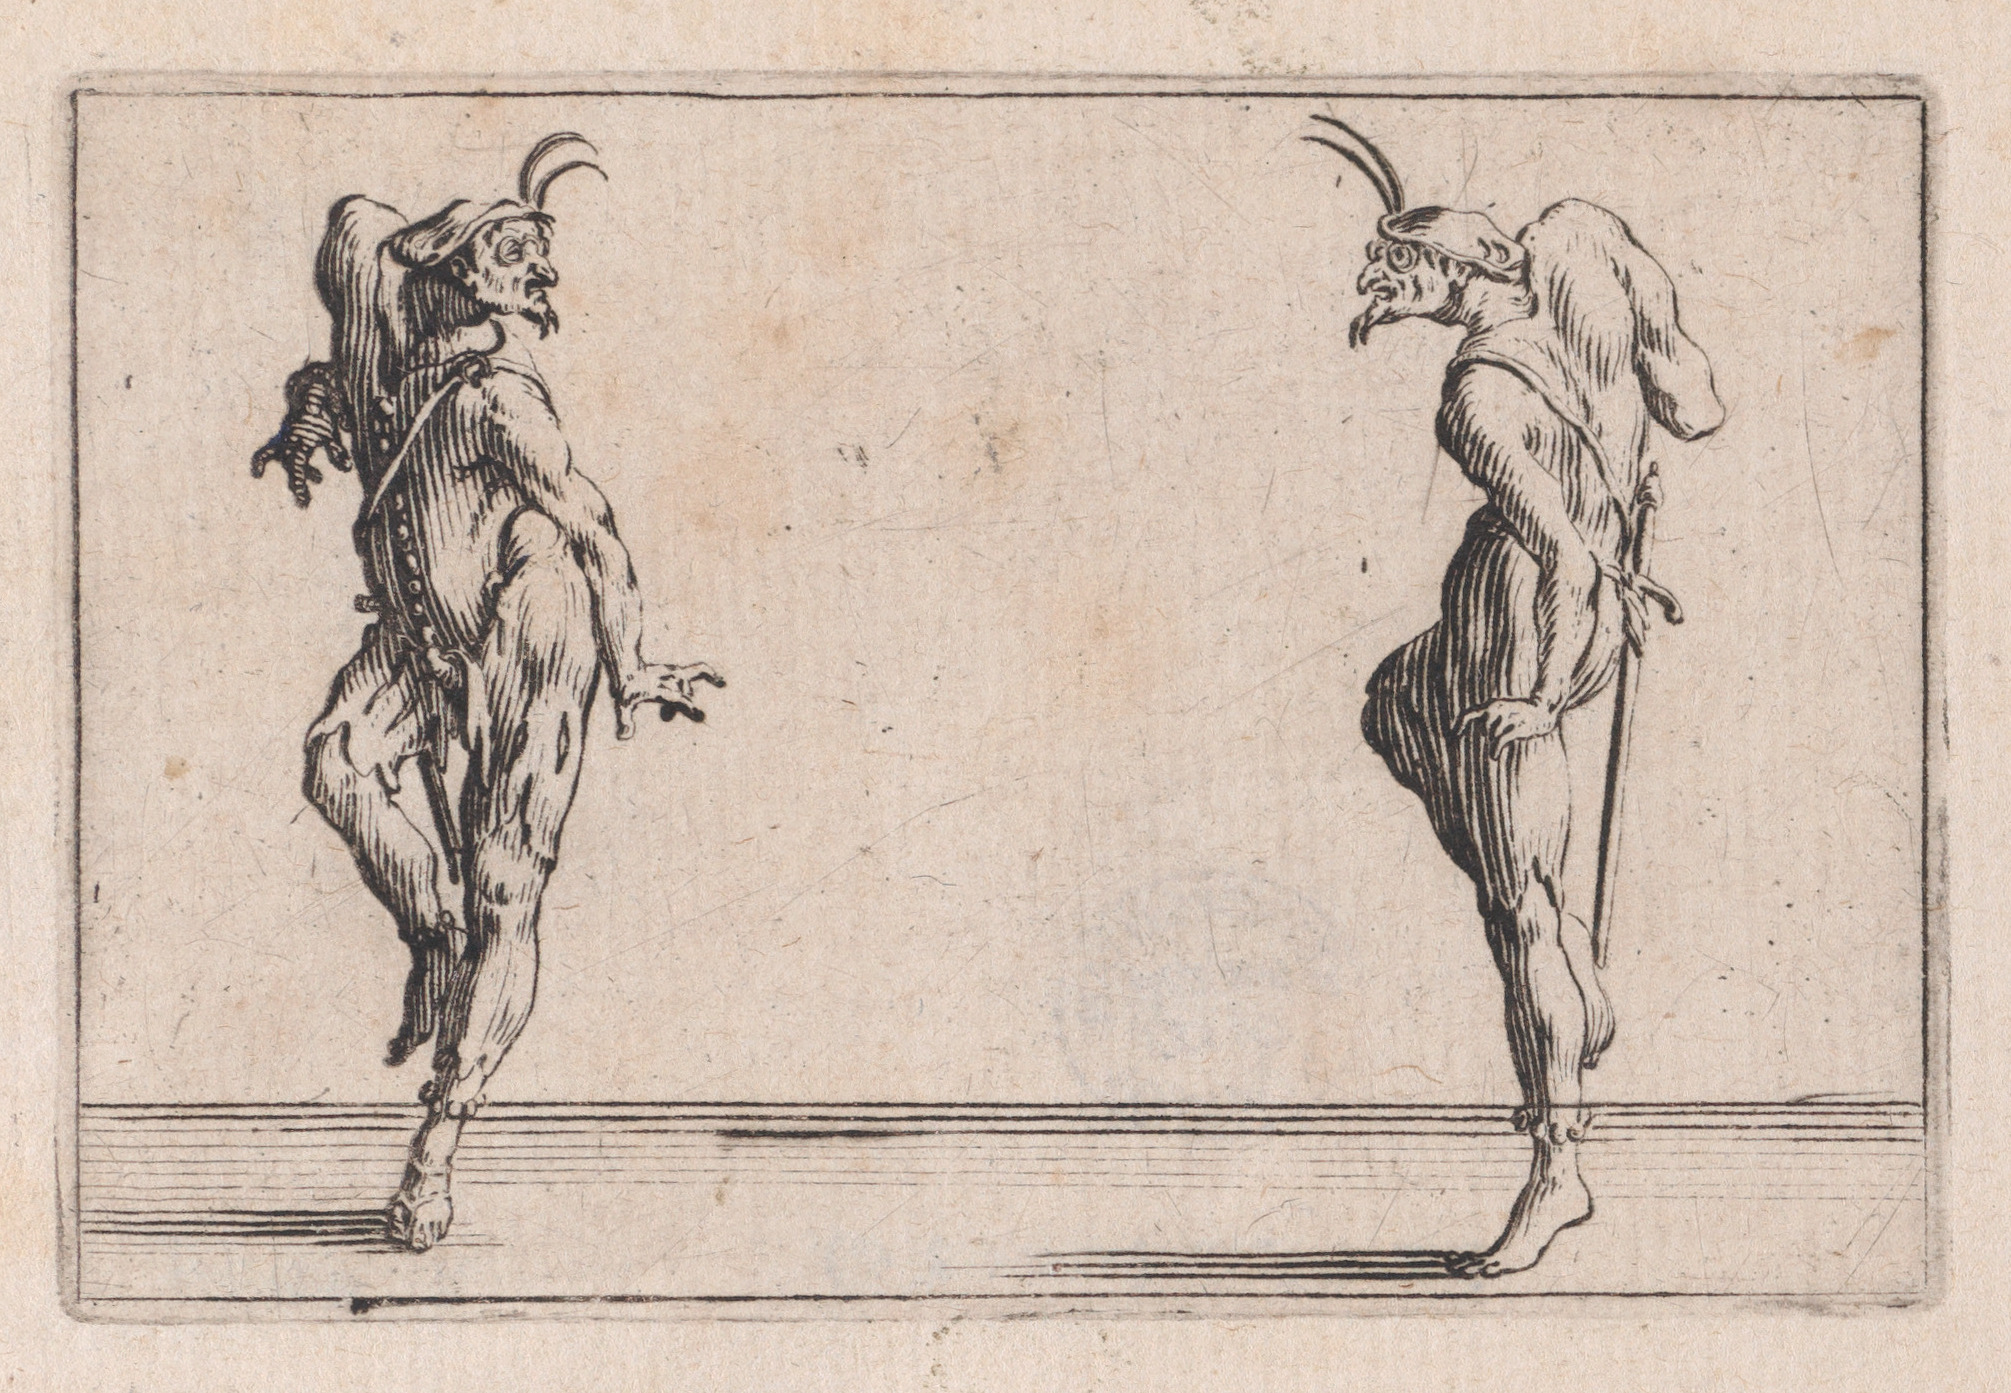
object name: print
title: Les Deux Pantalons se Regardant (Two Men in Pantsuits Looking at Each Other), from "Les Caprices" Series B, The Nancy Set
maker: jacques callot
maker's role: artist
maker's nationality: french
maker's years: 1592-1635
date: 1617-1620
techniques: etching